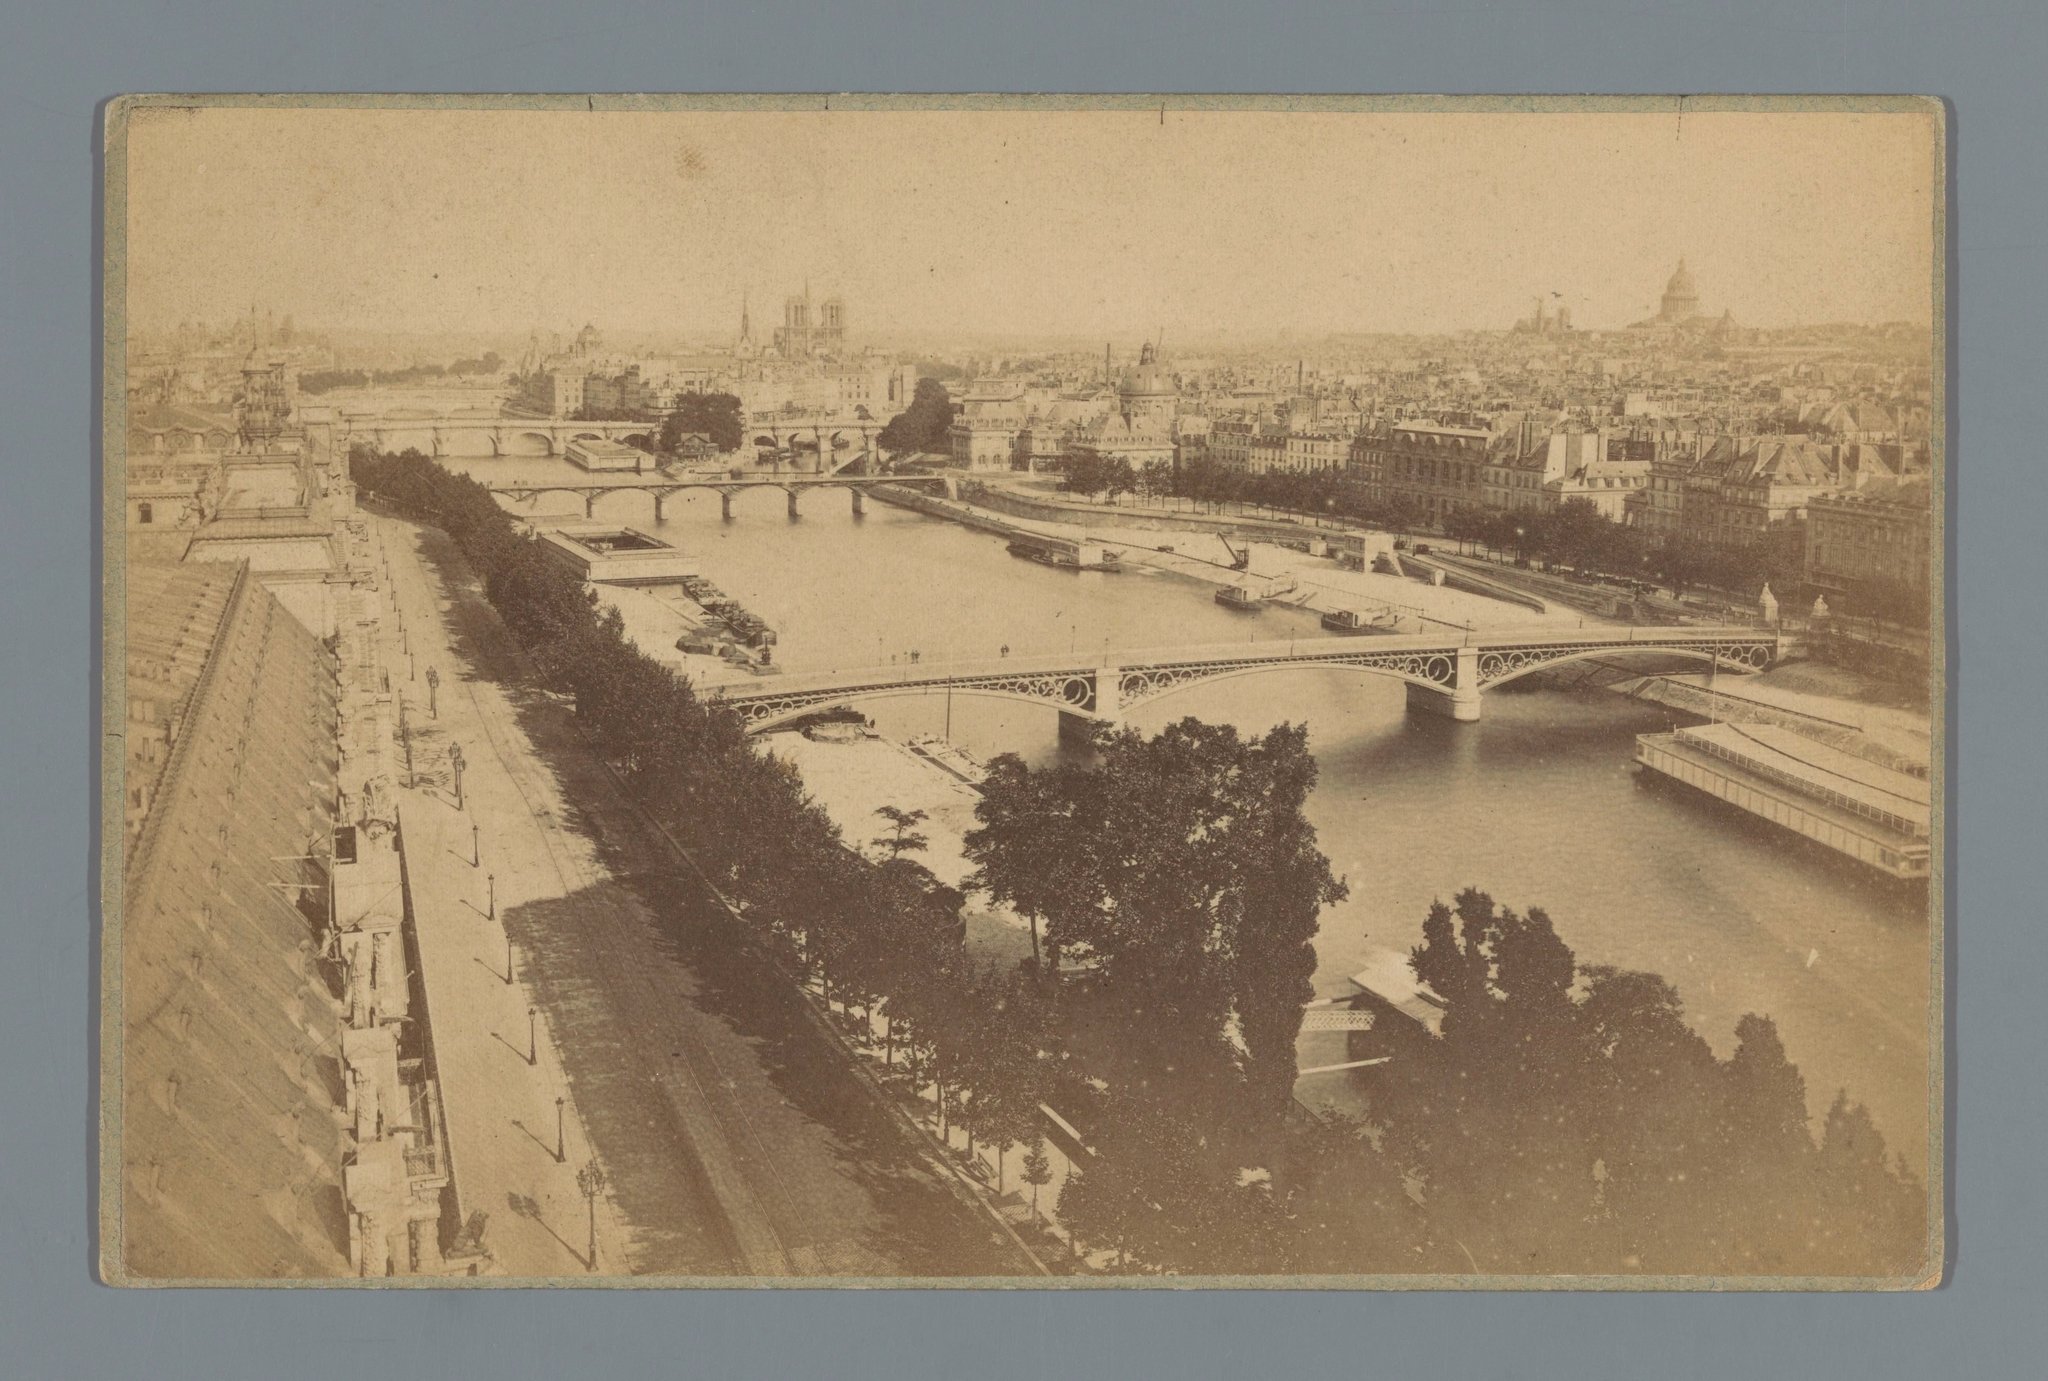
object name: photograph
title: Gezicht over de Seine op het Institut de France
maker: Anonymous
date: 1860-1890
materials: cardboard, photographic support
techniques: albumen print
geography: paris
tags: city-view, and landscape with man-made constructions, bridge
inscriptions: annotation: ‘Institut de France’